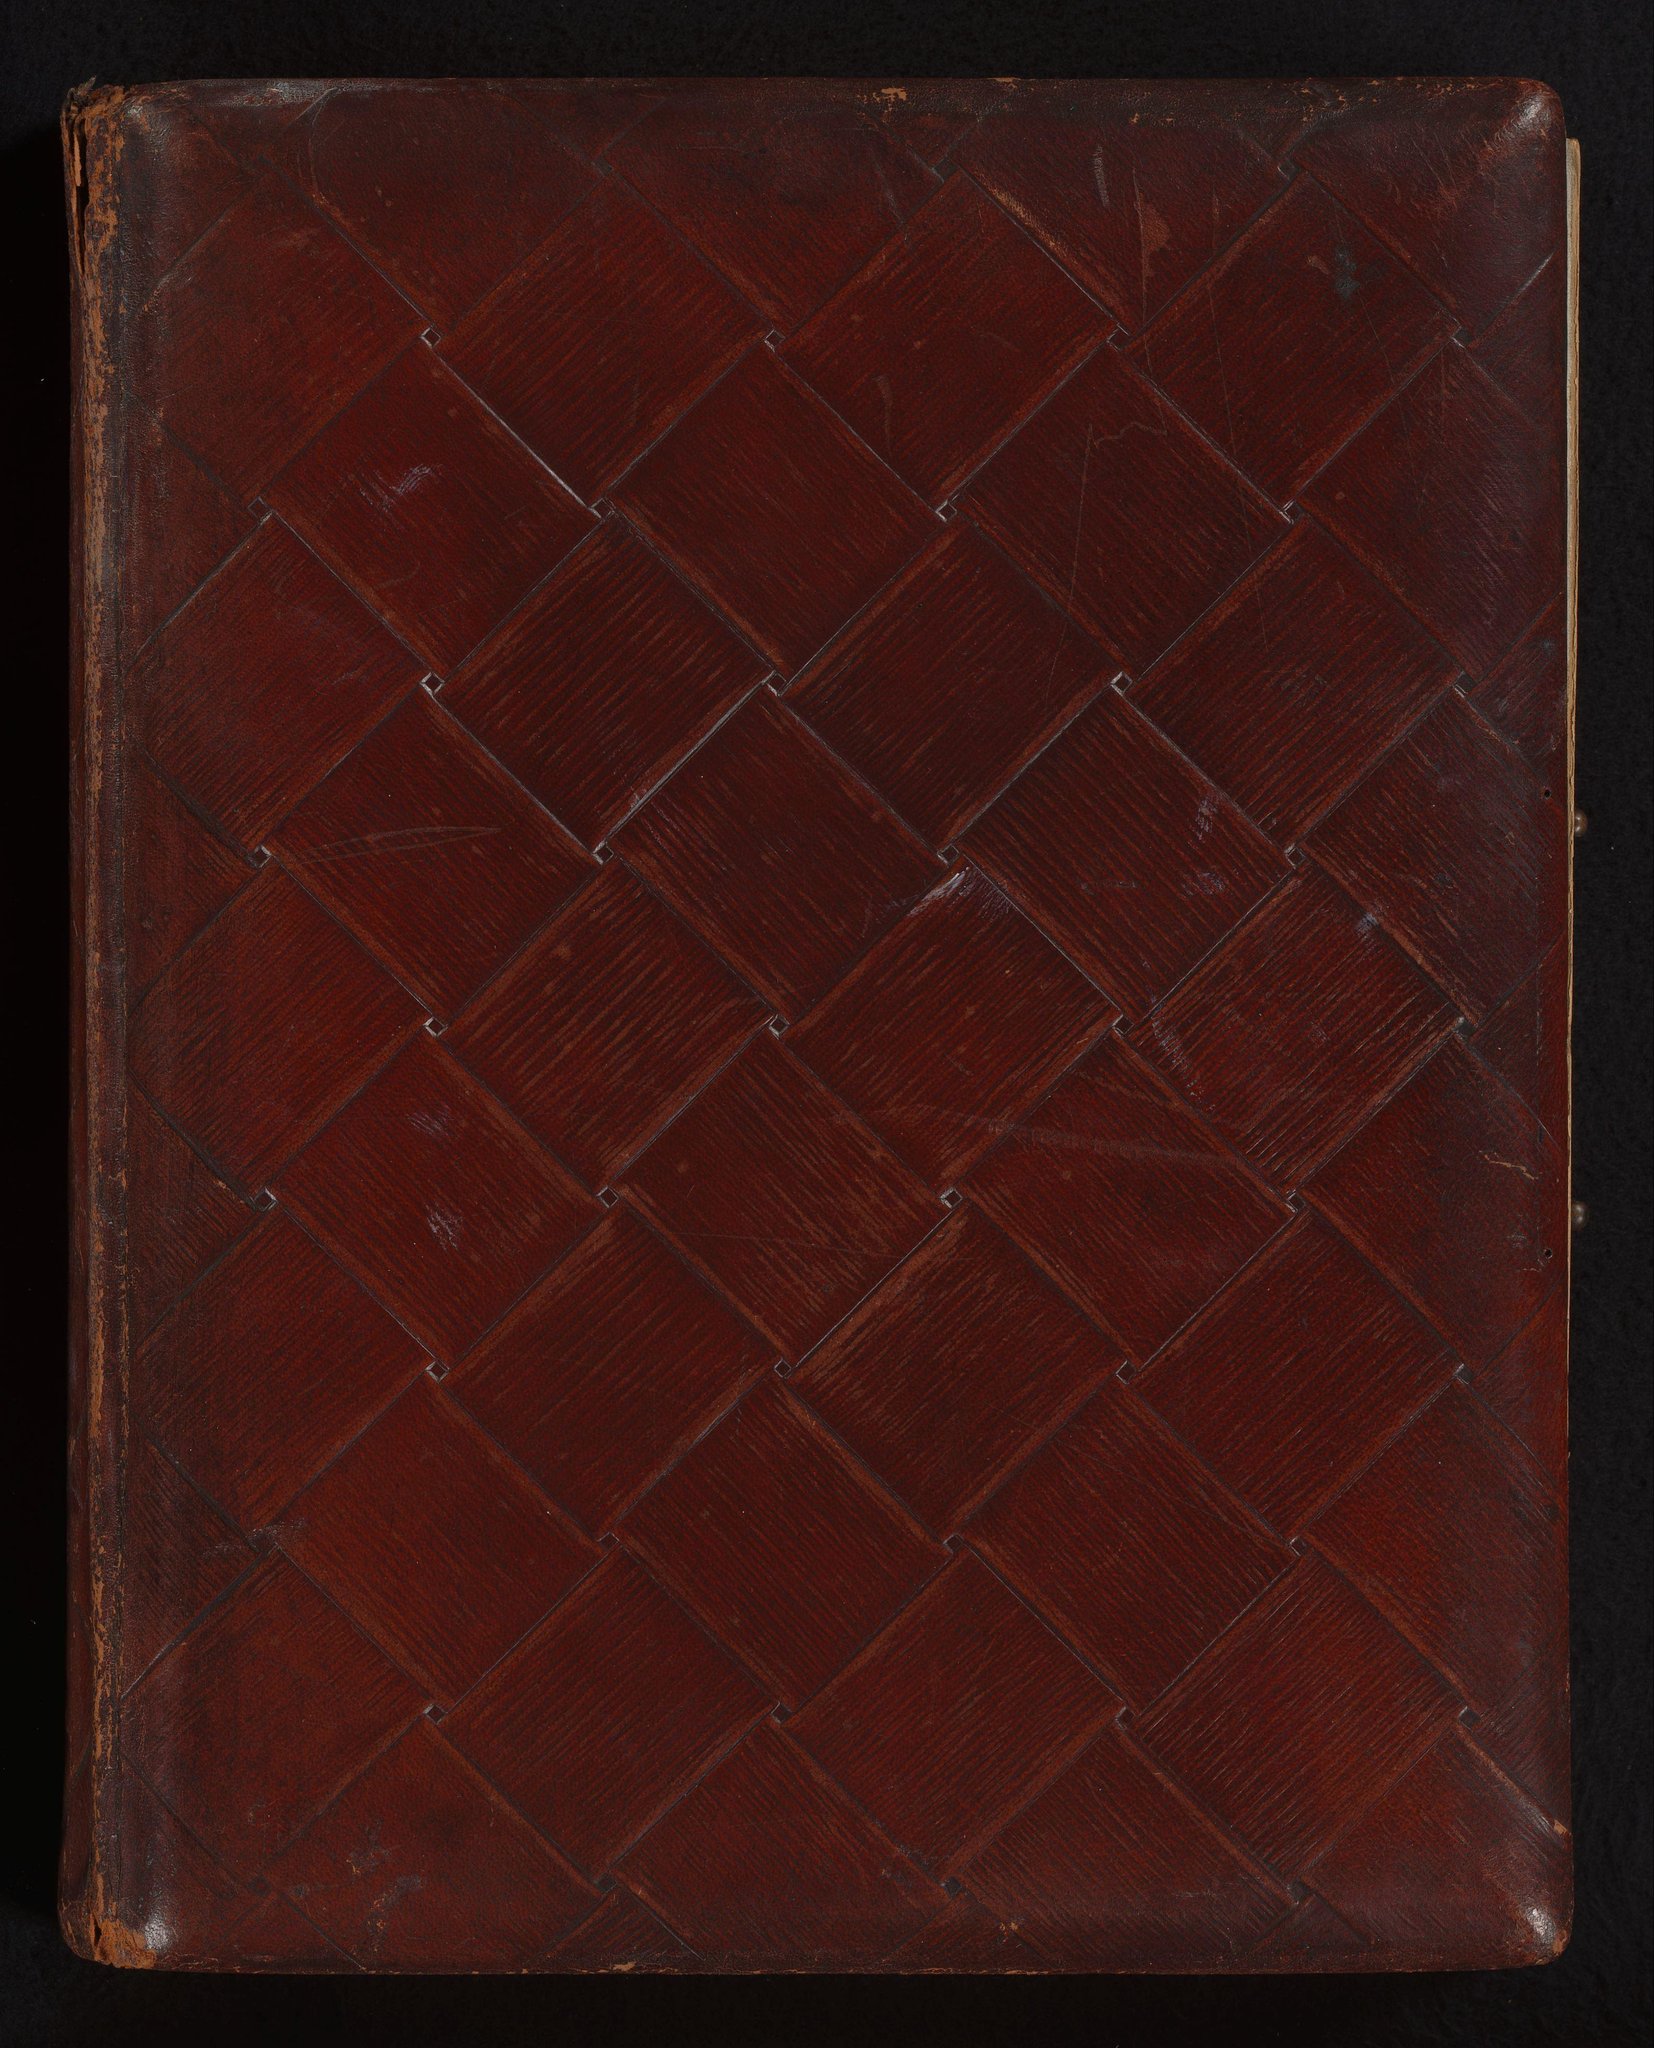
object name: slip in album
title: Engels familiealbum met 32 foto's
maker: Anonymous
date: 1880-1920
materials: cardboard, leather, metal, photographic support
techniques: platinum process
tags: adult woman, adult man, child, historical persons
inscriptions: inscription: ‘Dienst/ Verspreide/ Rijkskollekties (...)’, annotation: ‘Dec 6 1894/ L.X.’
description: Album met 32 pagina's en in totaal 32 foto's, waarvan twee los in het album. Bijna alle foto's zijn kabinetfoto's en portretten van mannen, vrouwen of kinderen.